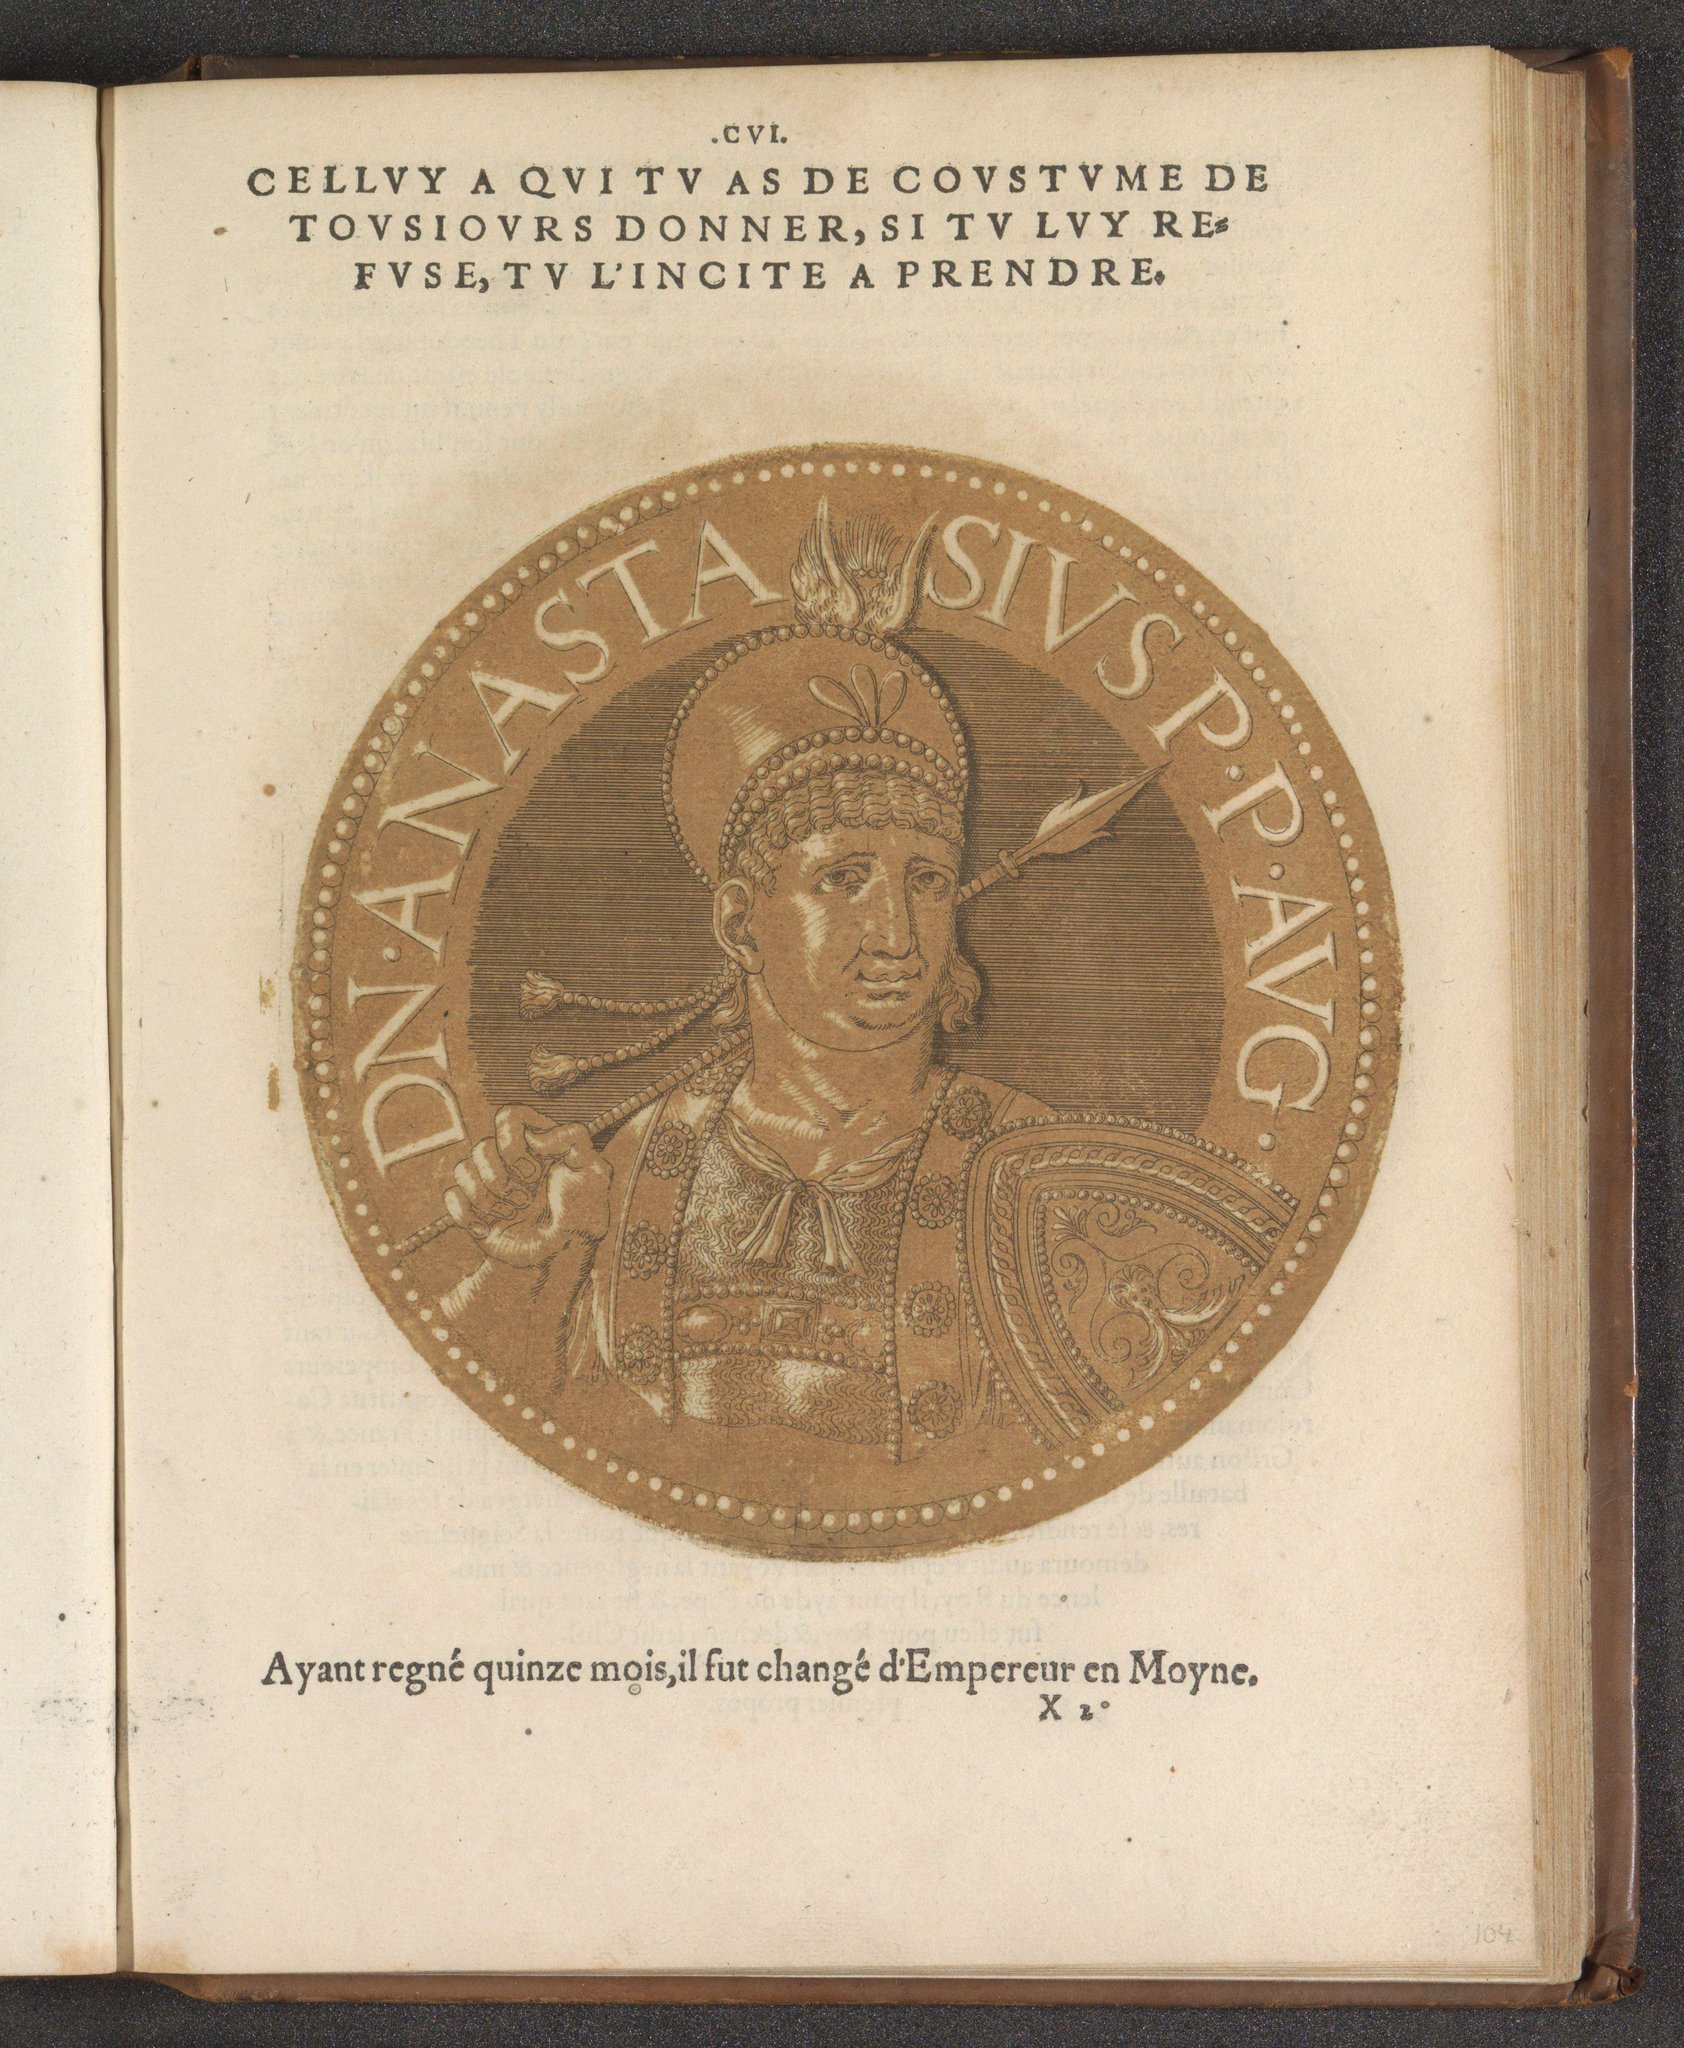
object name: print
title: Les images presque de tous les empereurs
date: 1557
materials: paper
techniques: woodcut, etching, letterpress printing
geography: antwerp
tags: emperor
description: Portretten van keizer Anastasios II, op een munt met randschrift. De prent maakt deel uit van een boek over de keizers vanaf Julius Caesar tot en met Karel V en zijn broer Ferdinand.